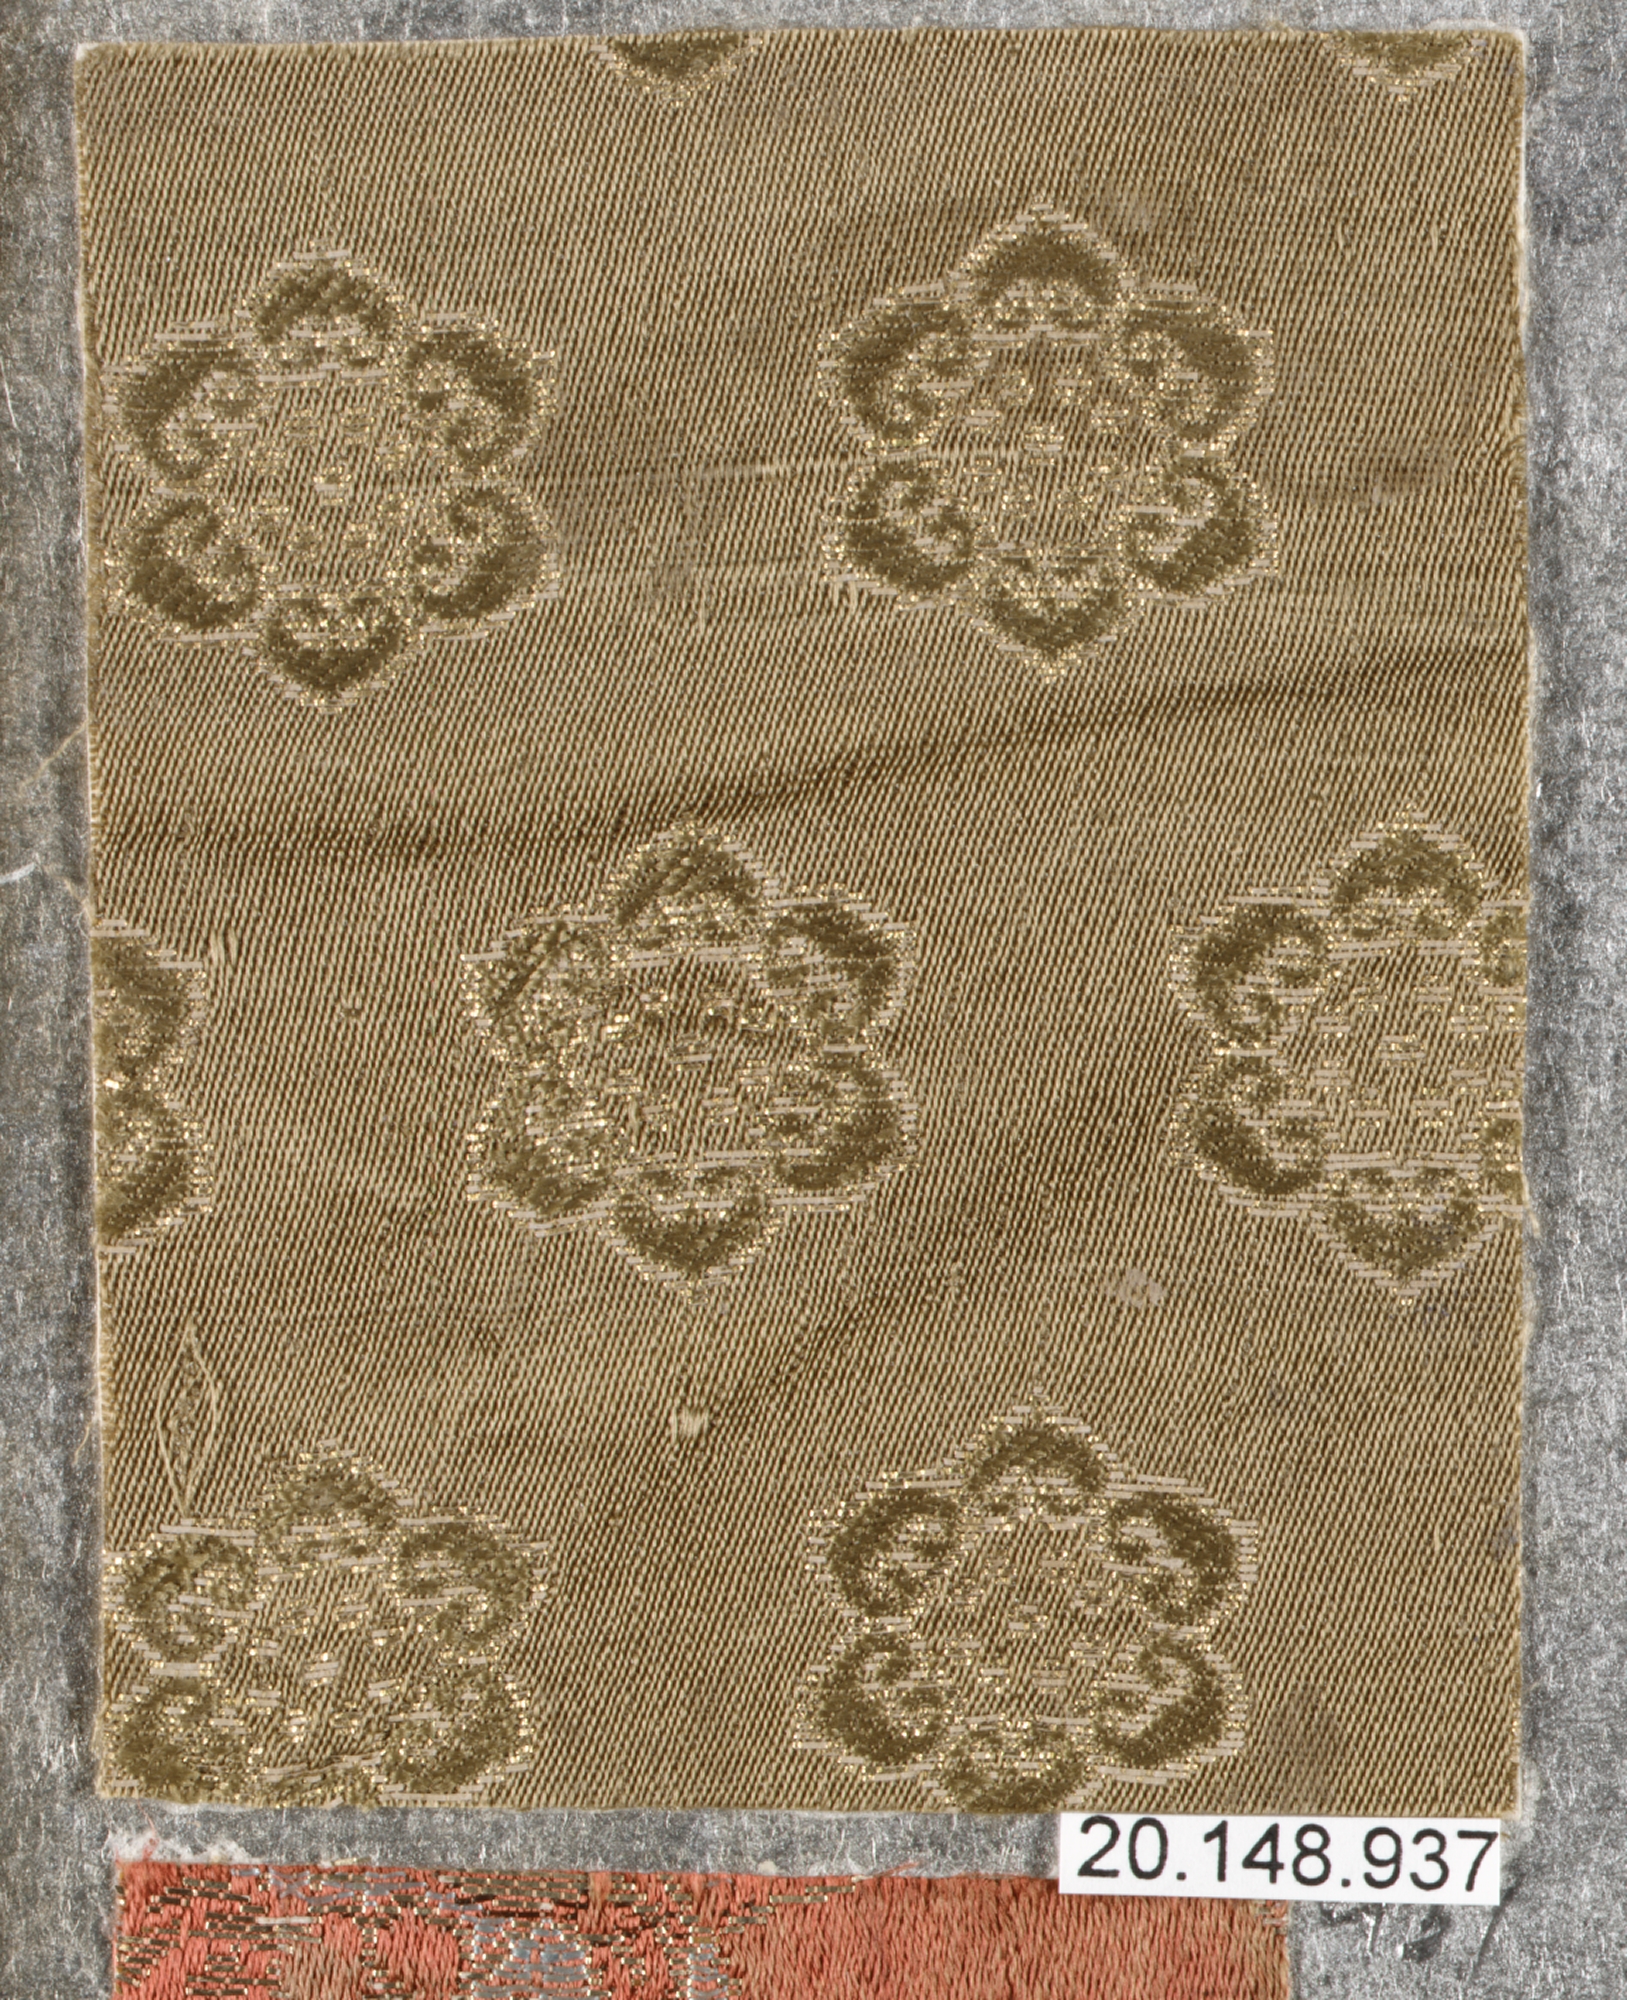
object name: piece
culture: japanese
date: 1601-1700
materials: silk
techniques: compound weave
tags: flowers